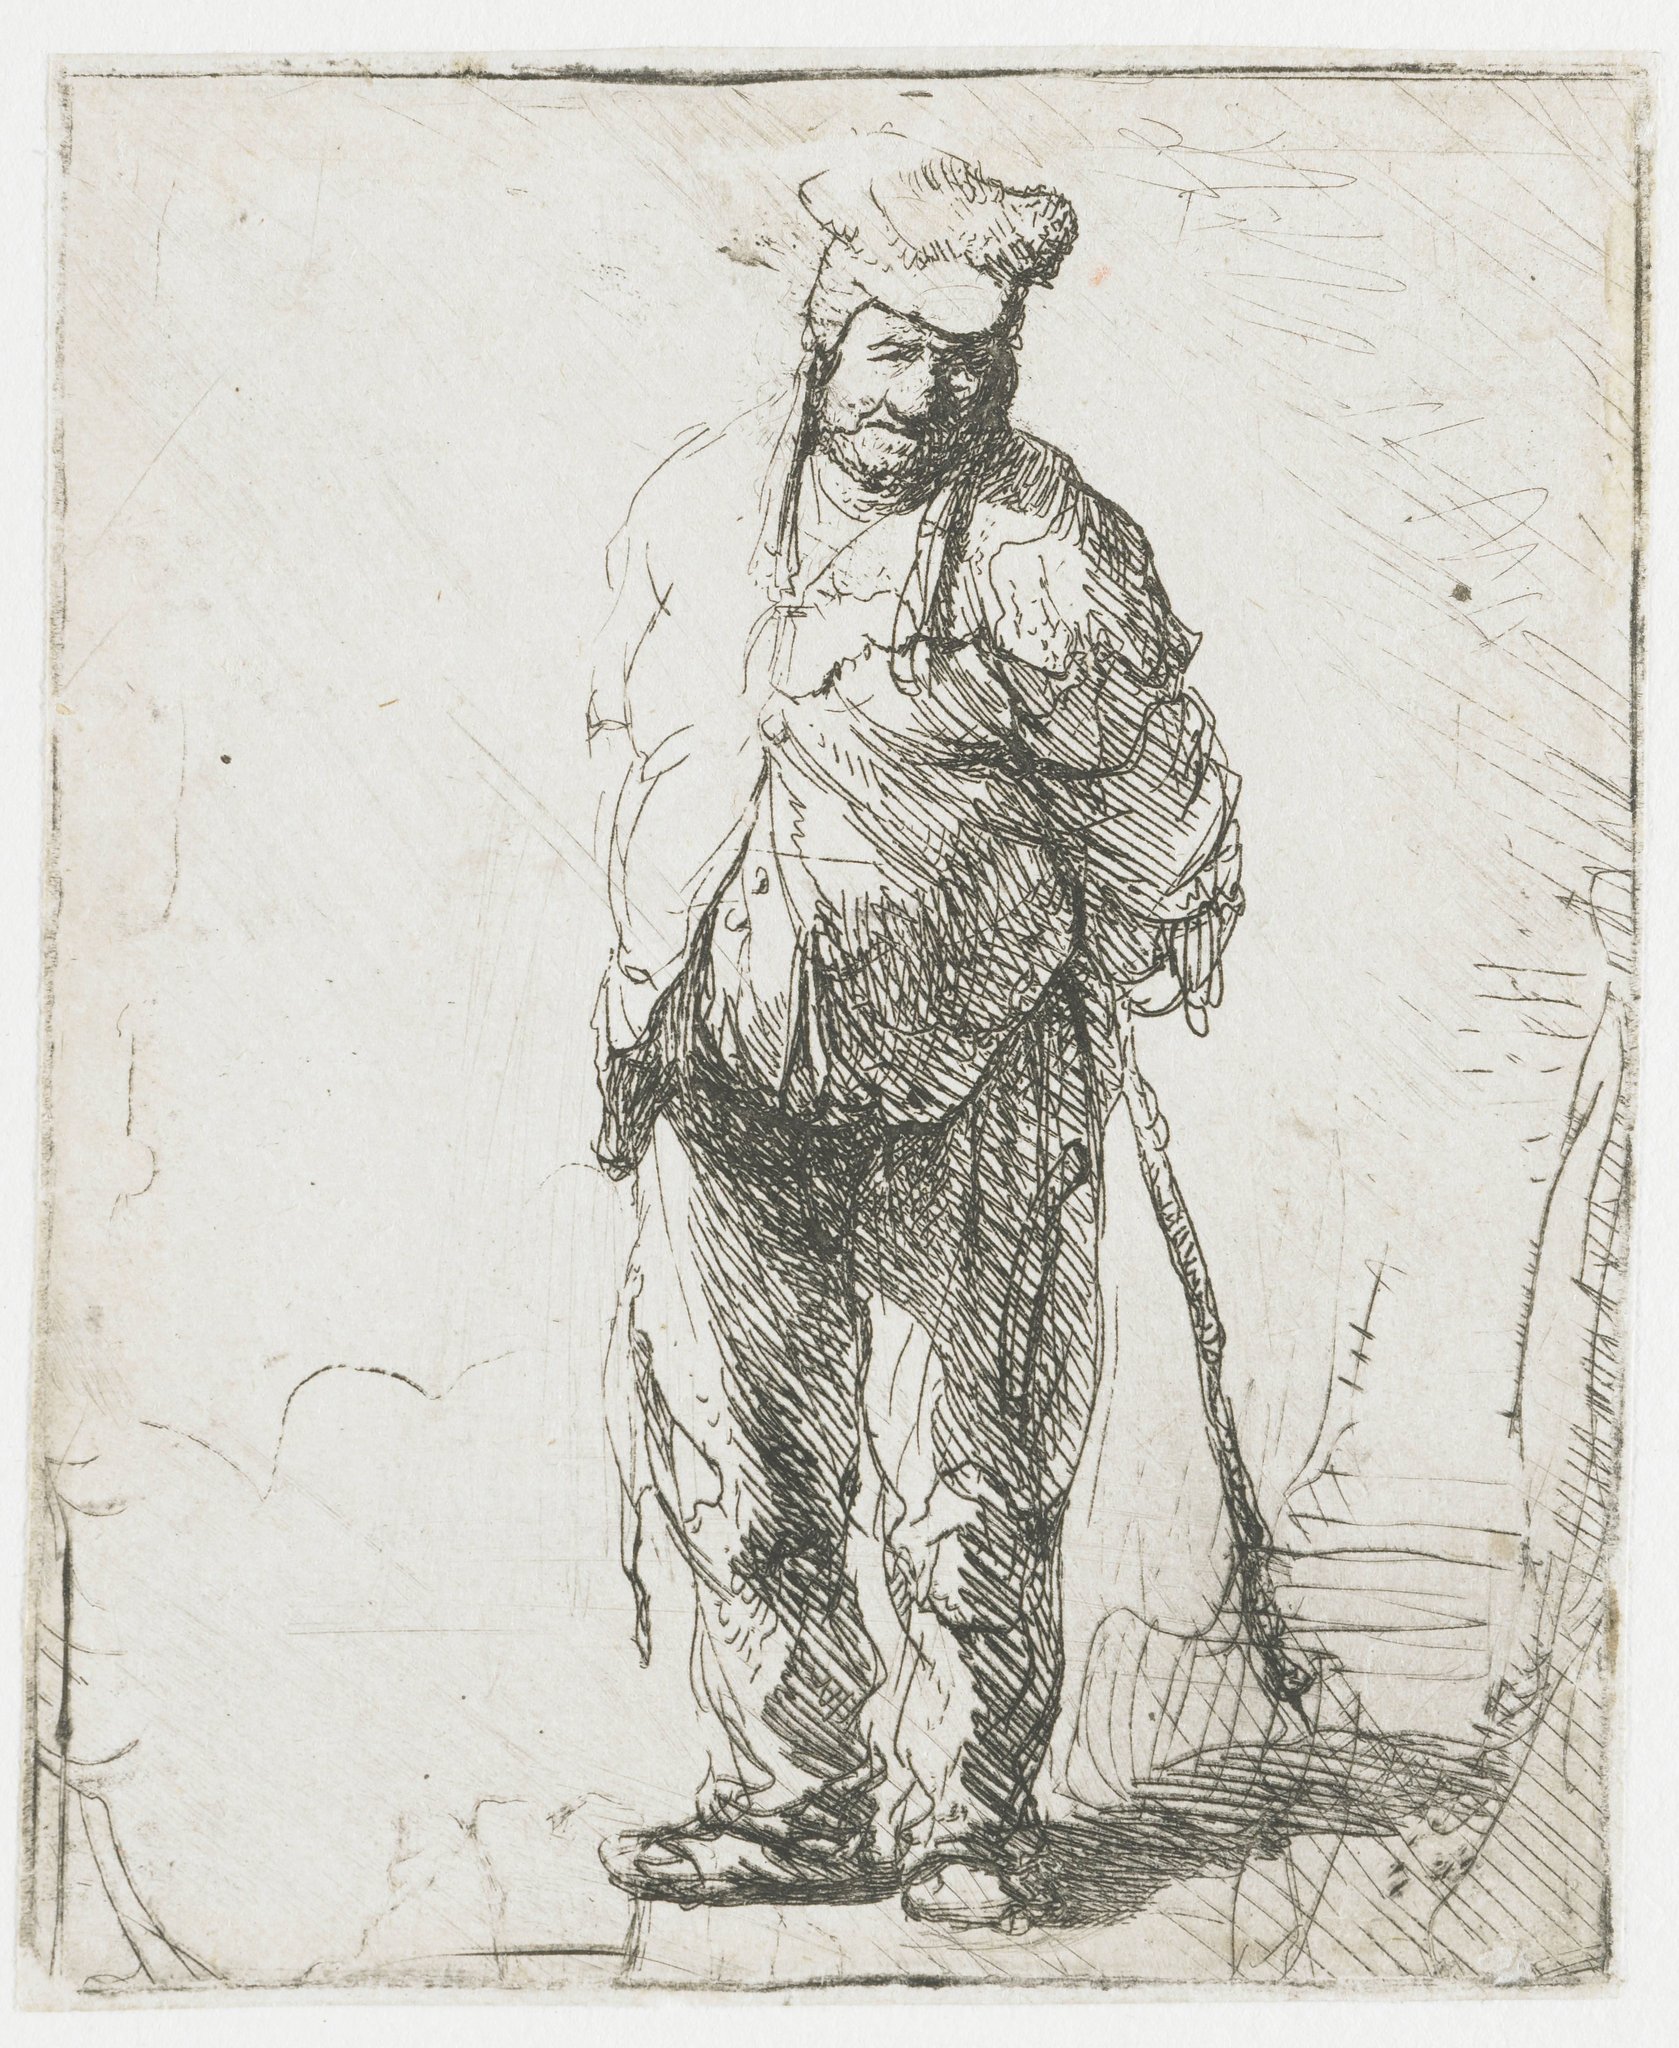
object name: print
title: Ragged peasant with his hands behind him, holding a stick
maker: rembrandt van rijn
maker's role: draughtsman, painter, print maker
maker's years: 1606-1669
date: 1630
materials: paper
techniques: drypoint, etching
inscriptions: collector's mark: Lugt 240